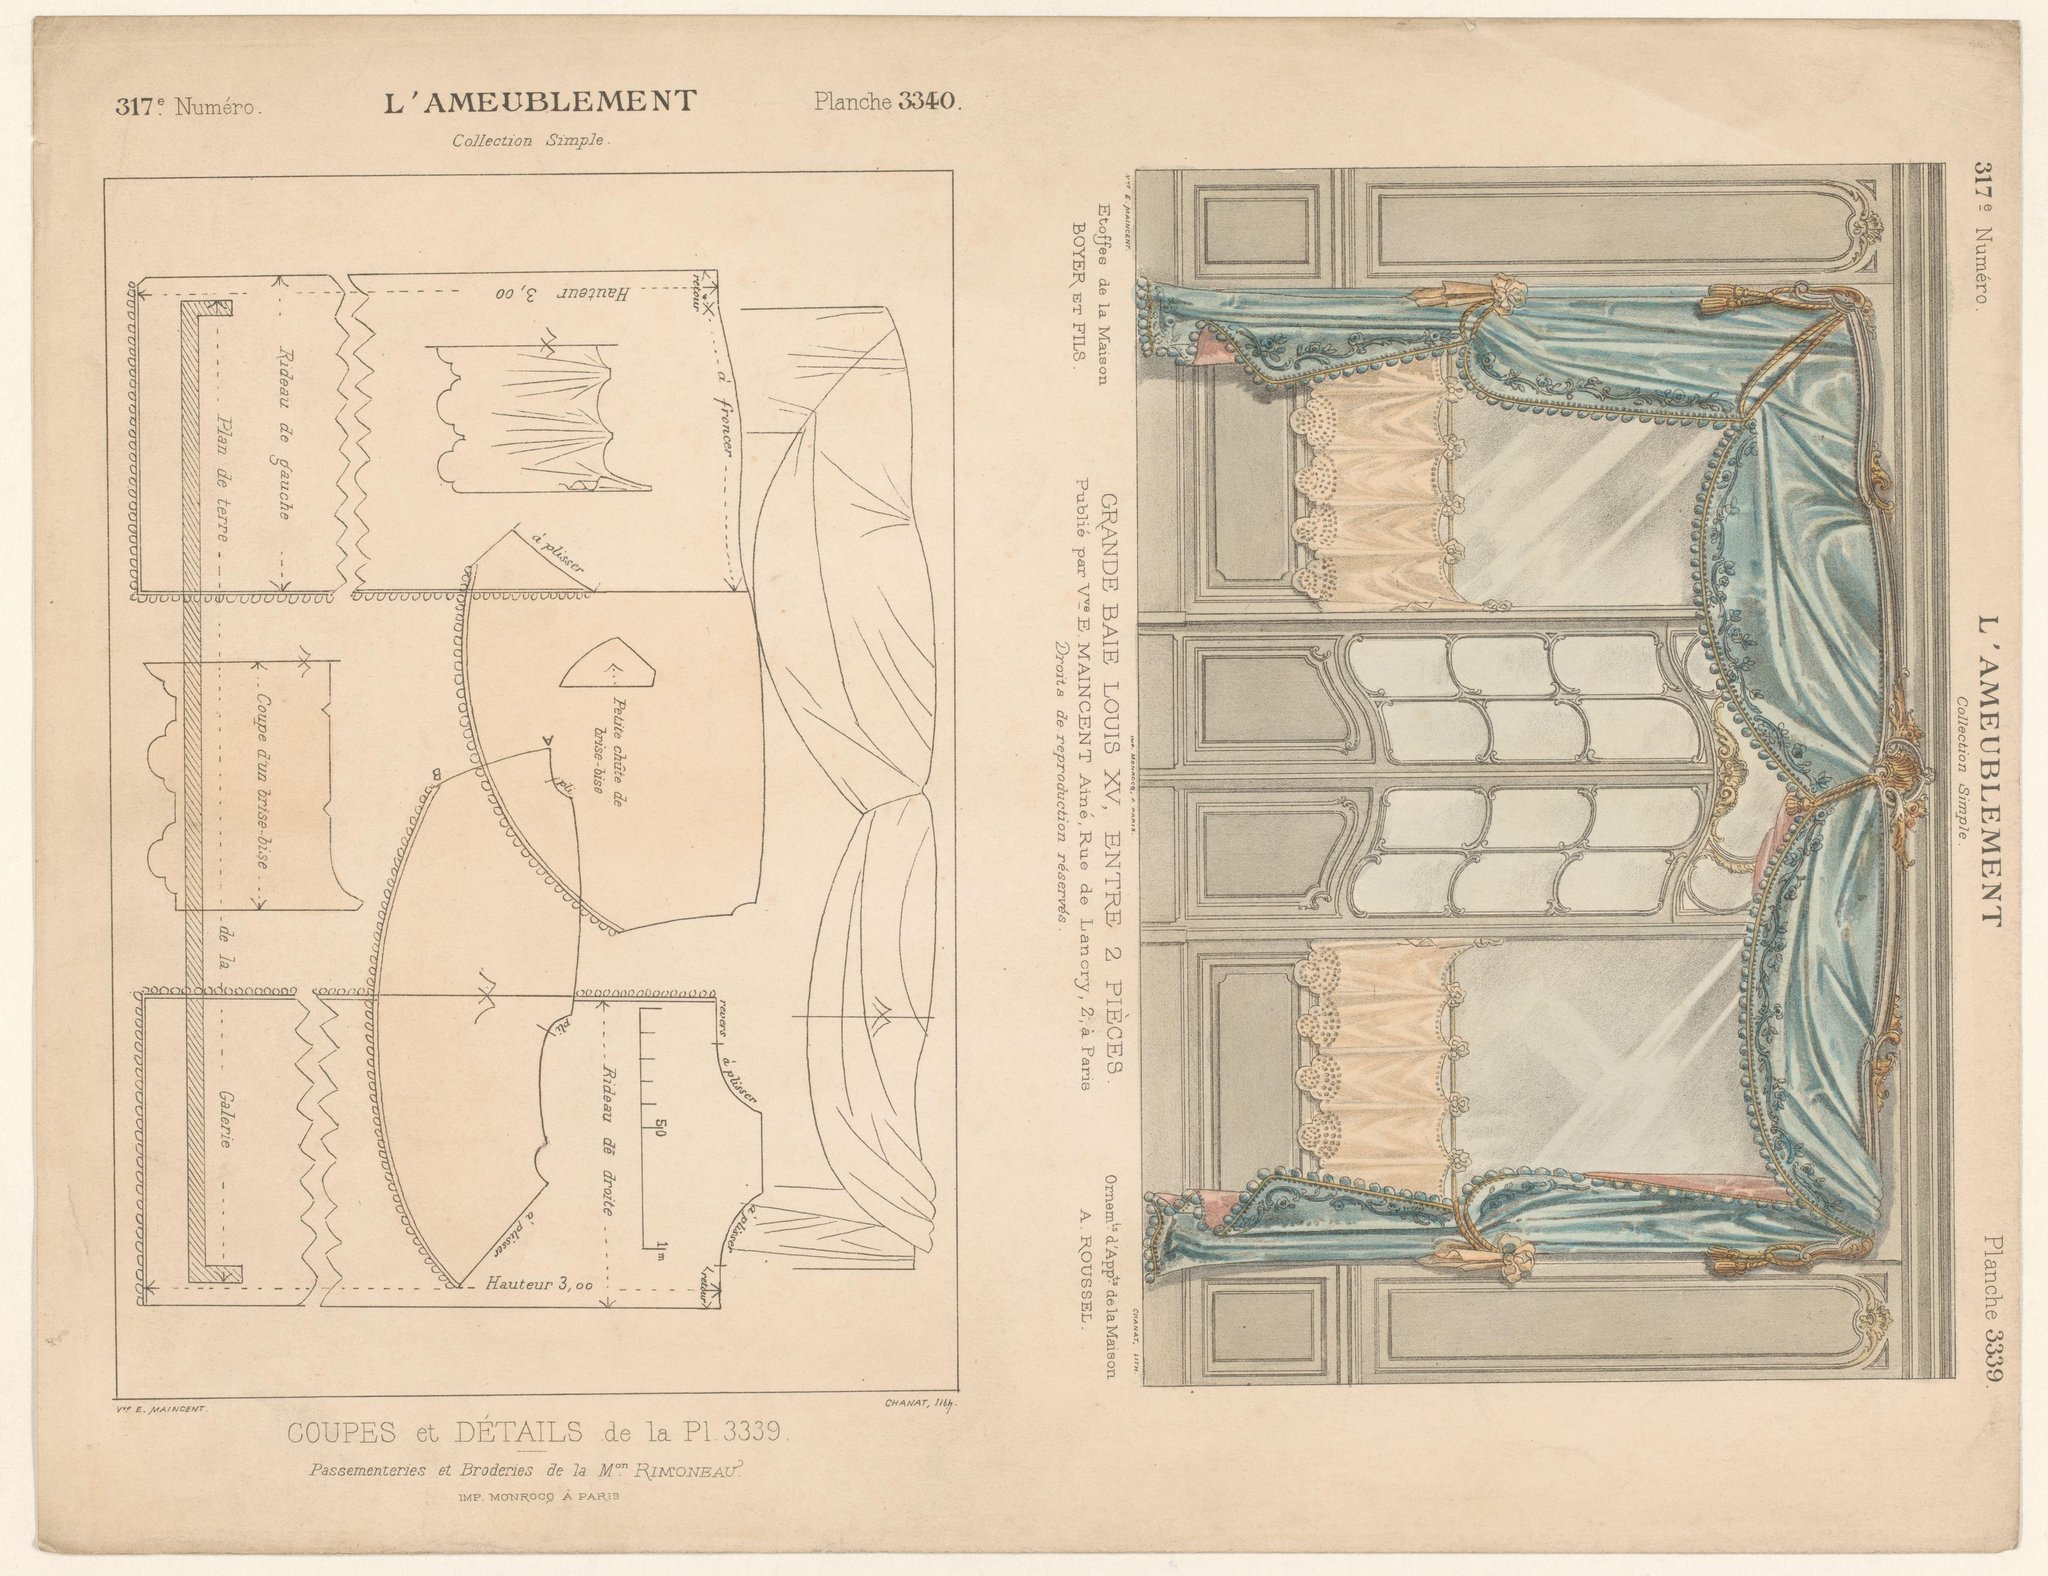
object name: print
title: Raampartij met gordijnen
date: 1895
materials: paper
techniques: hand coloring, lithograph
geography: paris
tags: window, door, hangings and drapery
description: Een raampartij met een deur en twee vensters met gedrapeerde gordijnen. Daar onder details van de draperieën. Prent uit 317e Livraison.